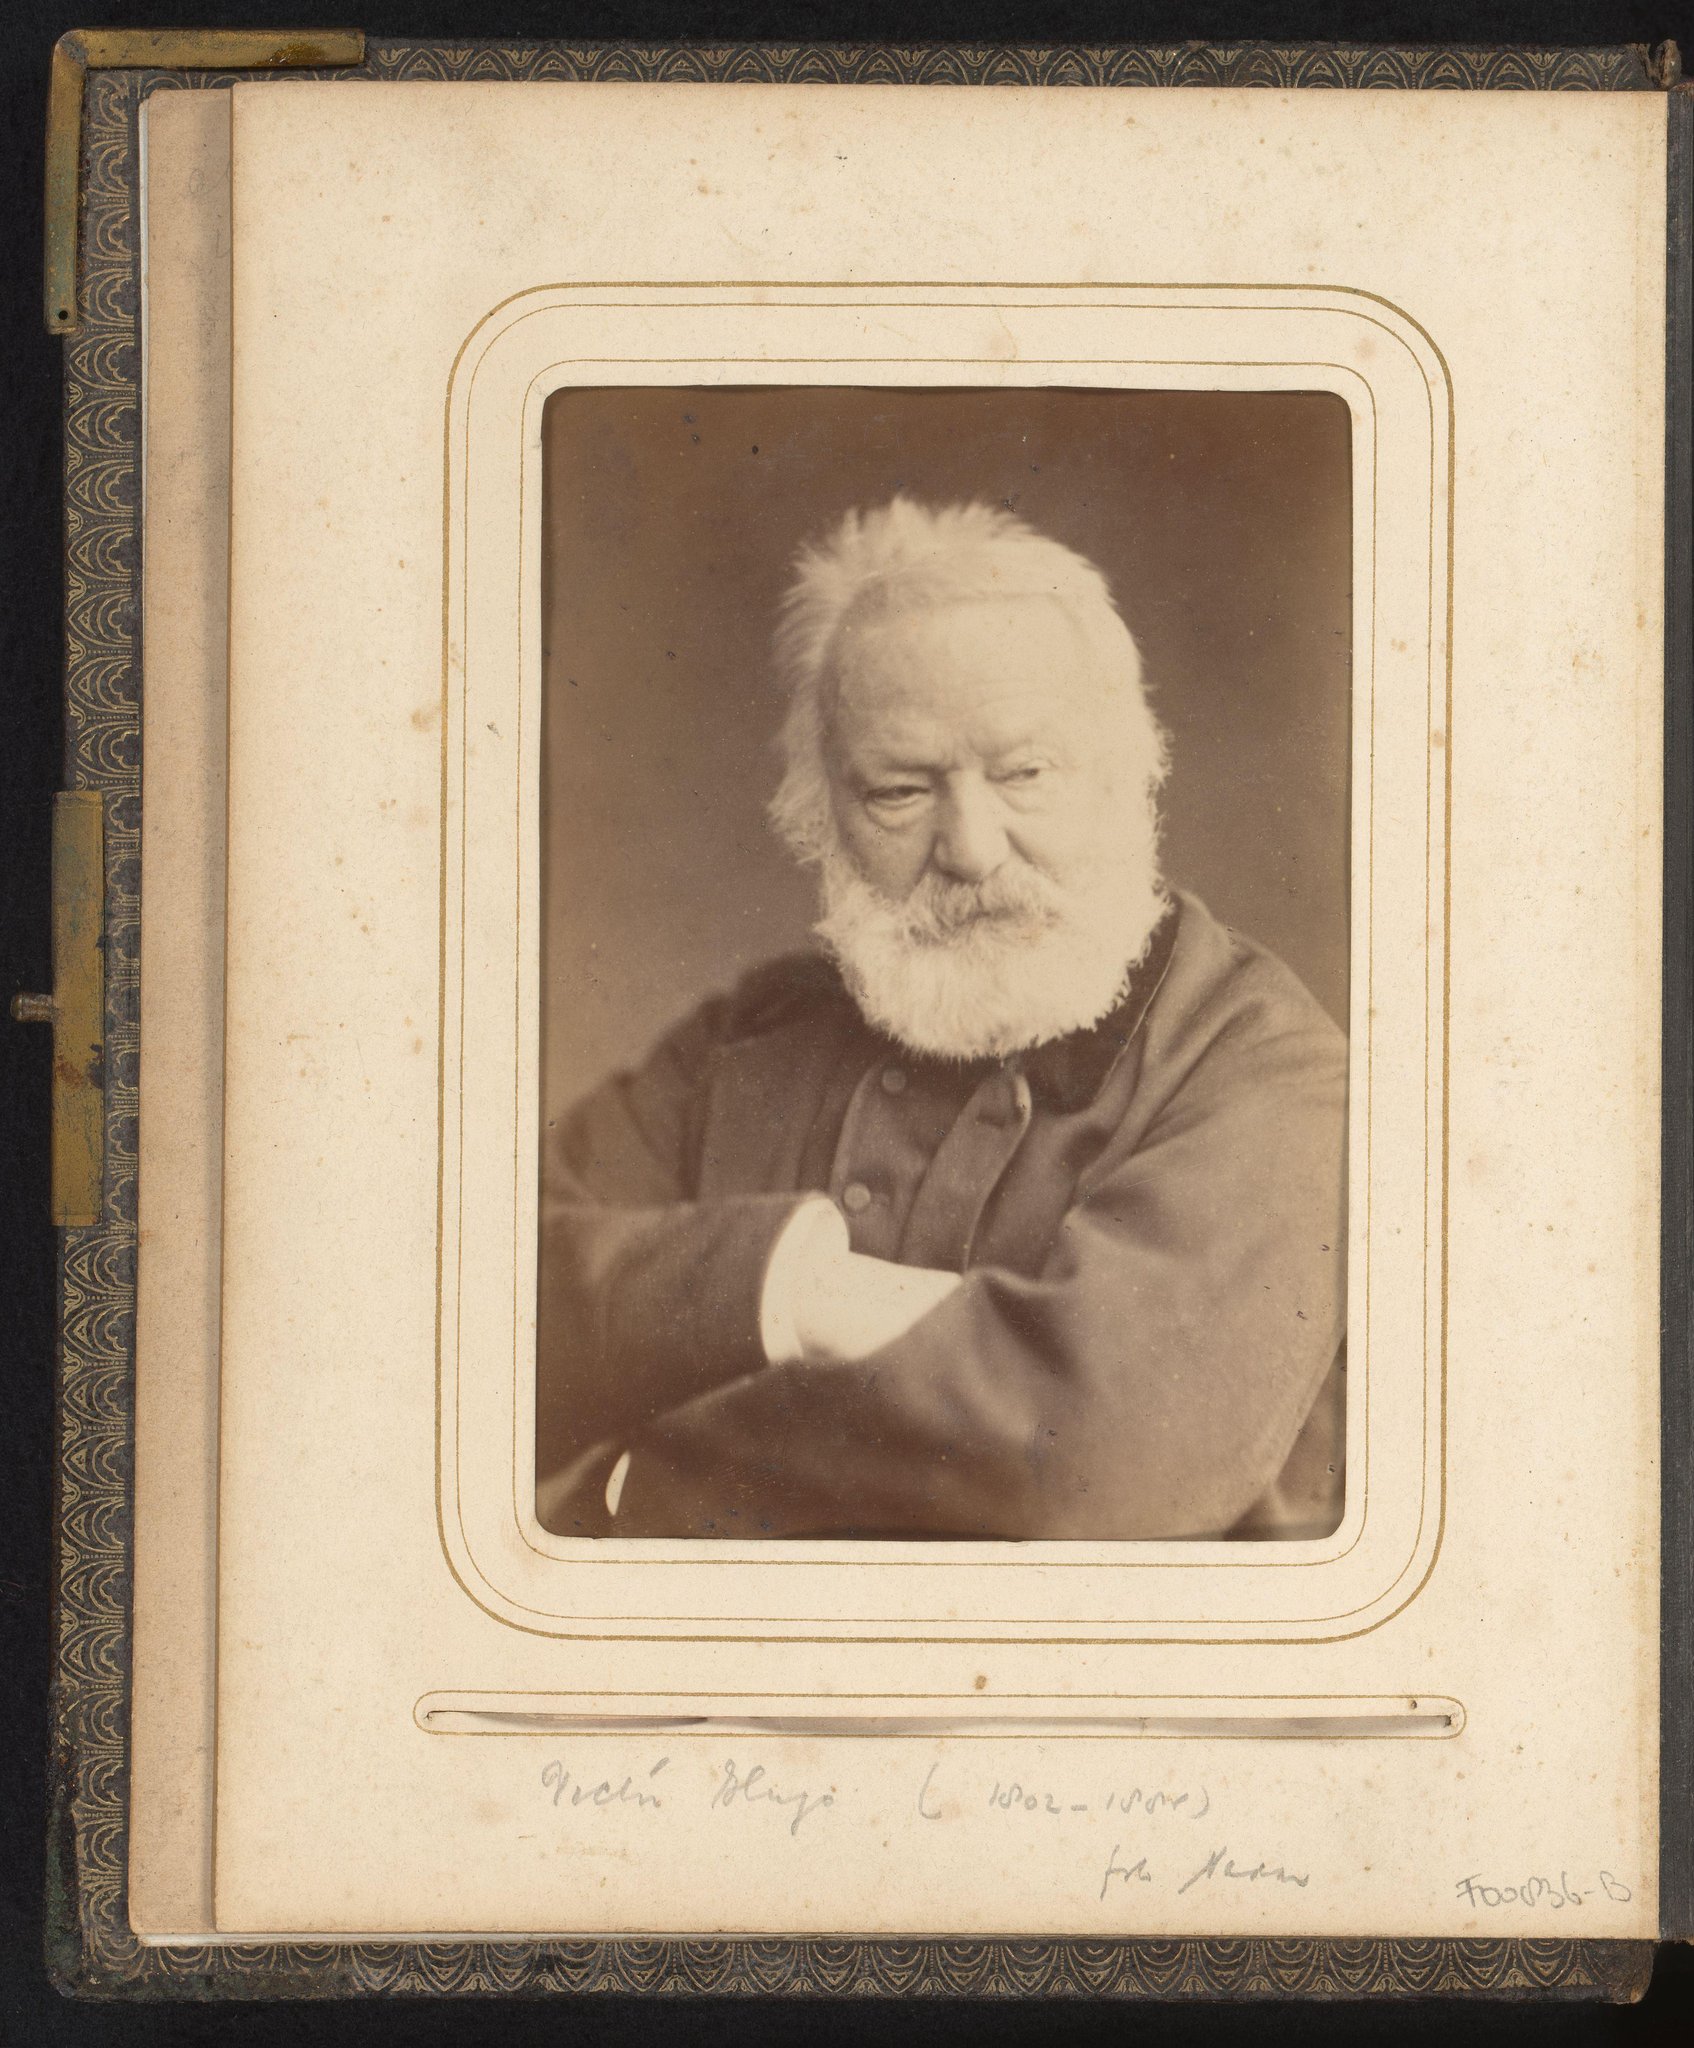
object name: album leaf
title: Portret van Victor Hugo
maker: félix nadar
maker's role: ballonvaarder, fotograaf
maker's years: 1820-1910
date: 1878-1885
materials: cardboard, photographic support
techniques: albumen print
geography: paris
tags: paris, victor hugo, historical persons, portrait of a writer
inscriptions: annotation: ‘Victor Hugo (1802 - 1885)/ foto Nadar’, inscription: ‘Médaille d'or/ Exposition Universelle 1878/ Nadar/ Rue d'Anjou, 51 (...)’, annotation: ‘1.20/ 10’